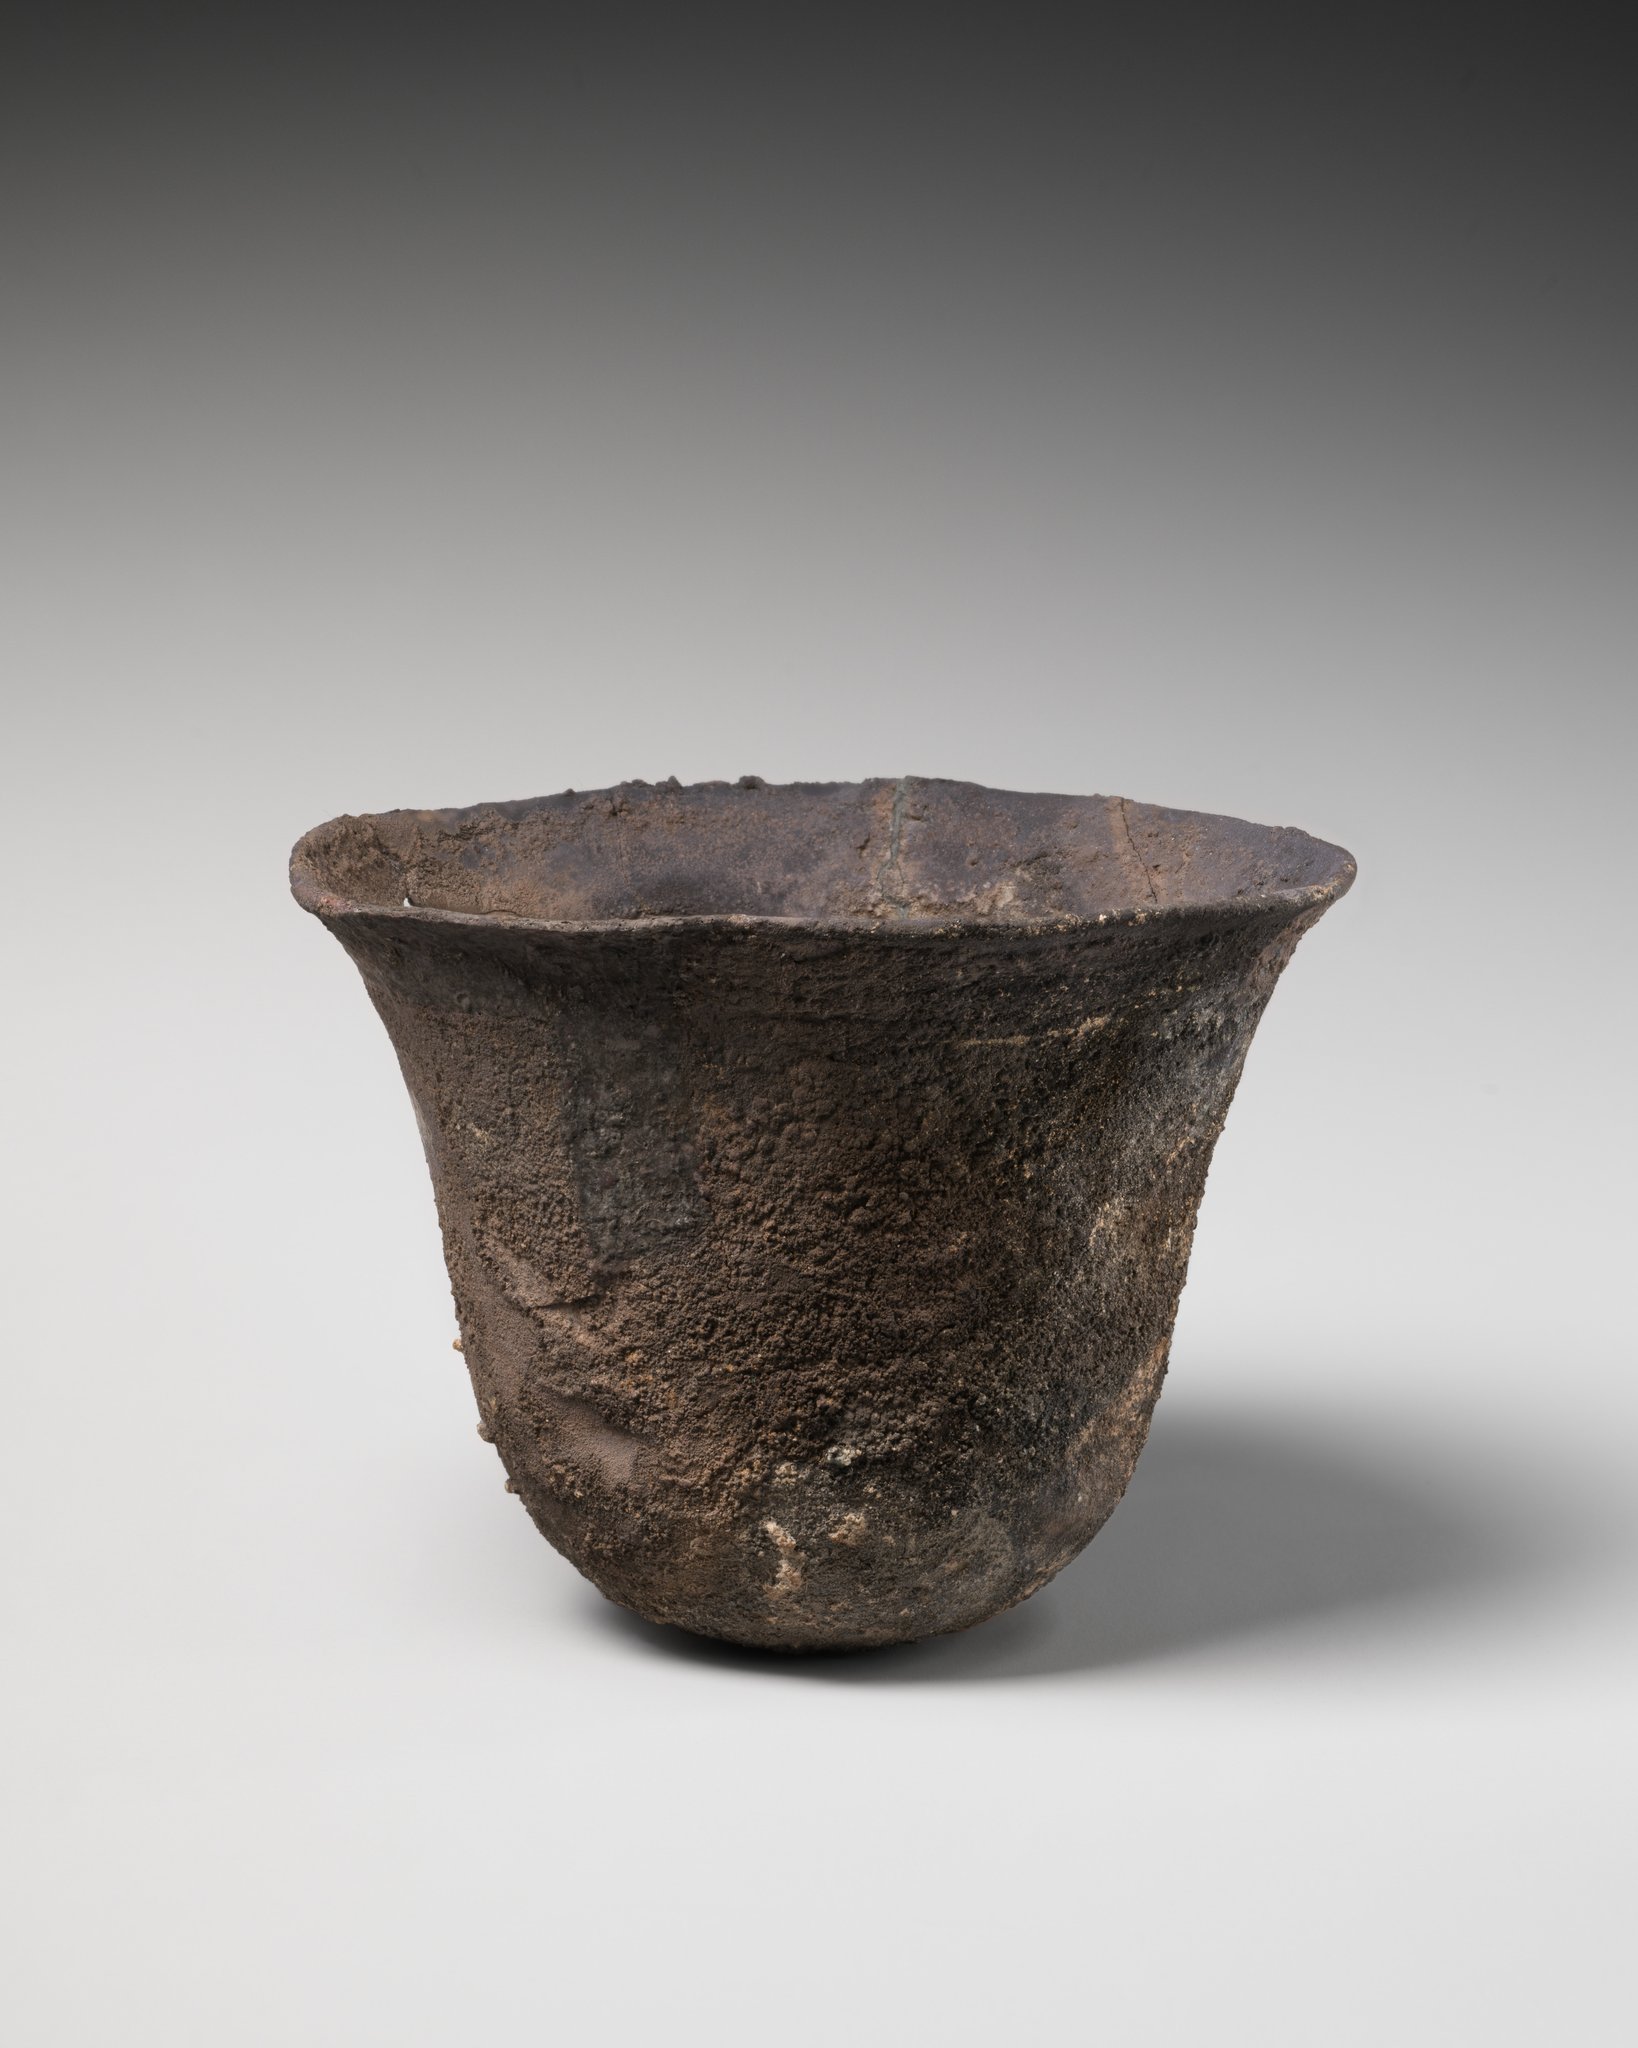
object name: cup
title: Silver cup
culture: cypriot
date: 600-501 BCE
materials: silver